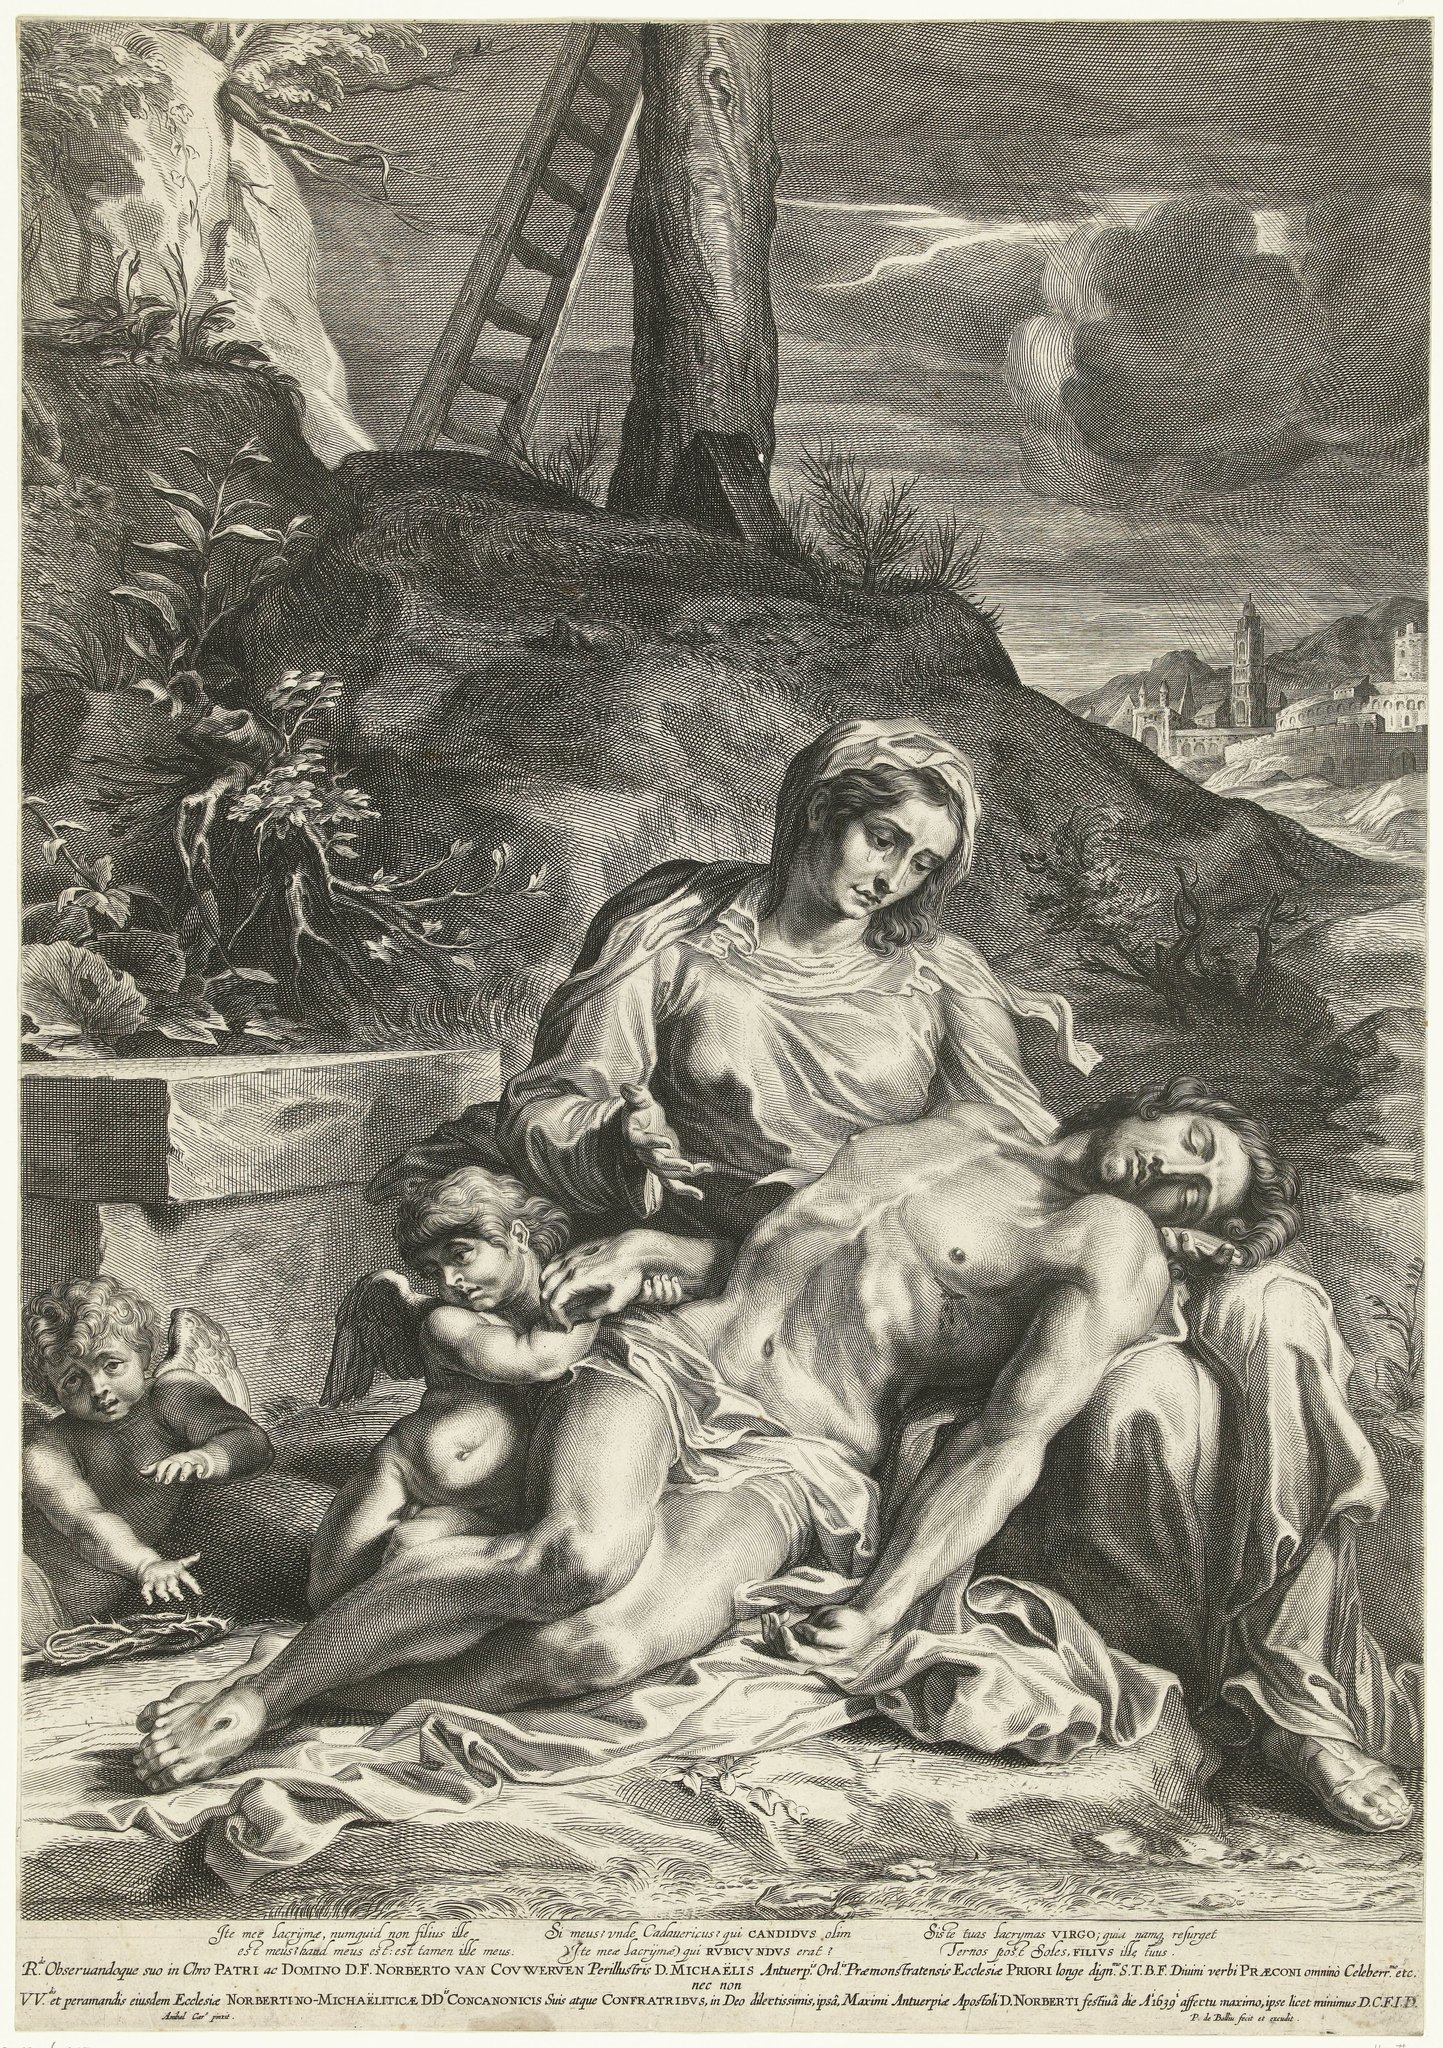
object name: print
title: Maria met dode lichaam van Christus op schoot, zittend onder het kruis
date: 1639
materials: paper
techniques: engraving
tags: 'pietà ', 'vesperbild', 'marienklage' (no others present): christ, either with or without crown of thorns, mourned by mary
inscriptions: collector's mark: Lugt 240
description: Maria met dode lichaam van Christus op schoot, zittend onder het kruis. In de marge onder een vers in zes regels Latijn.